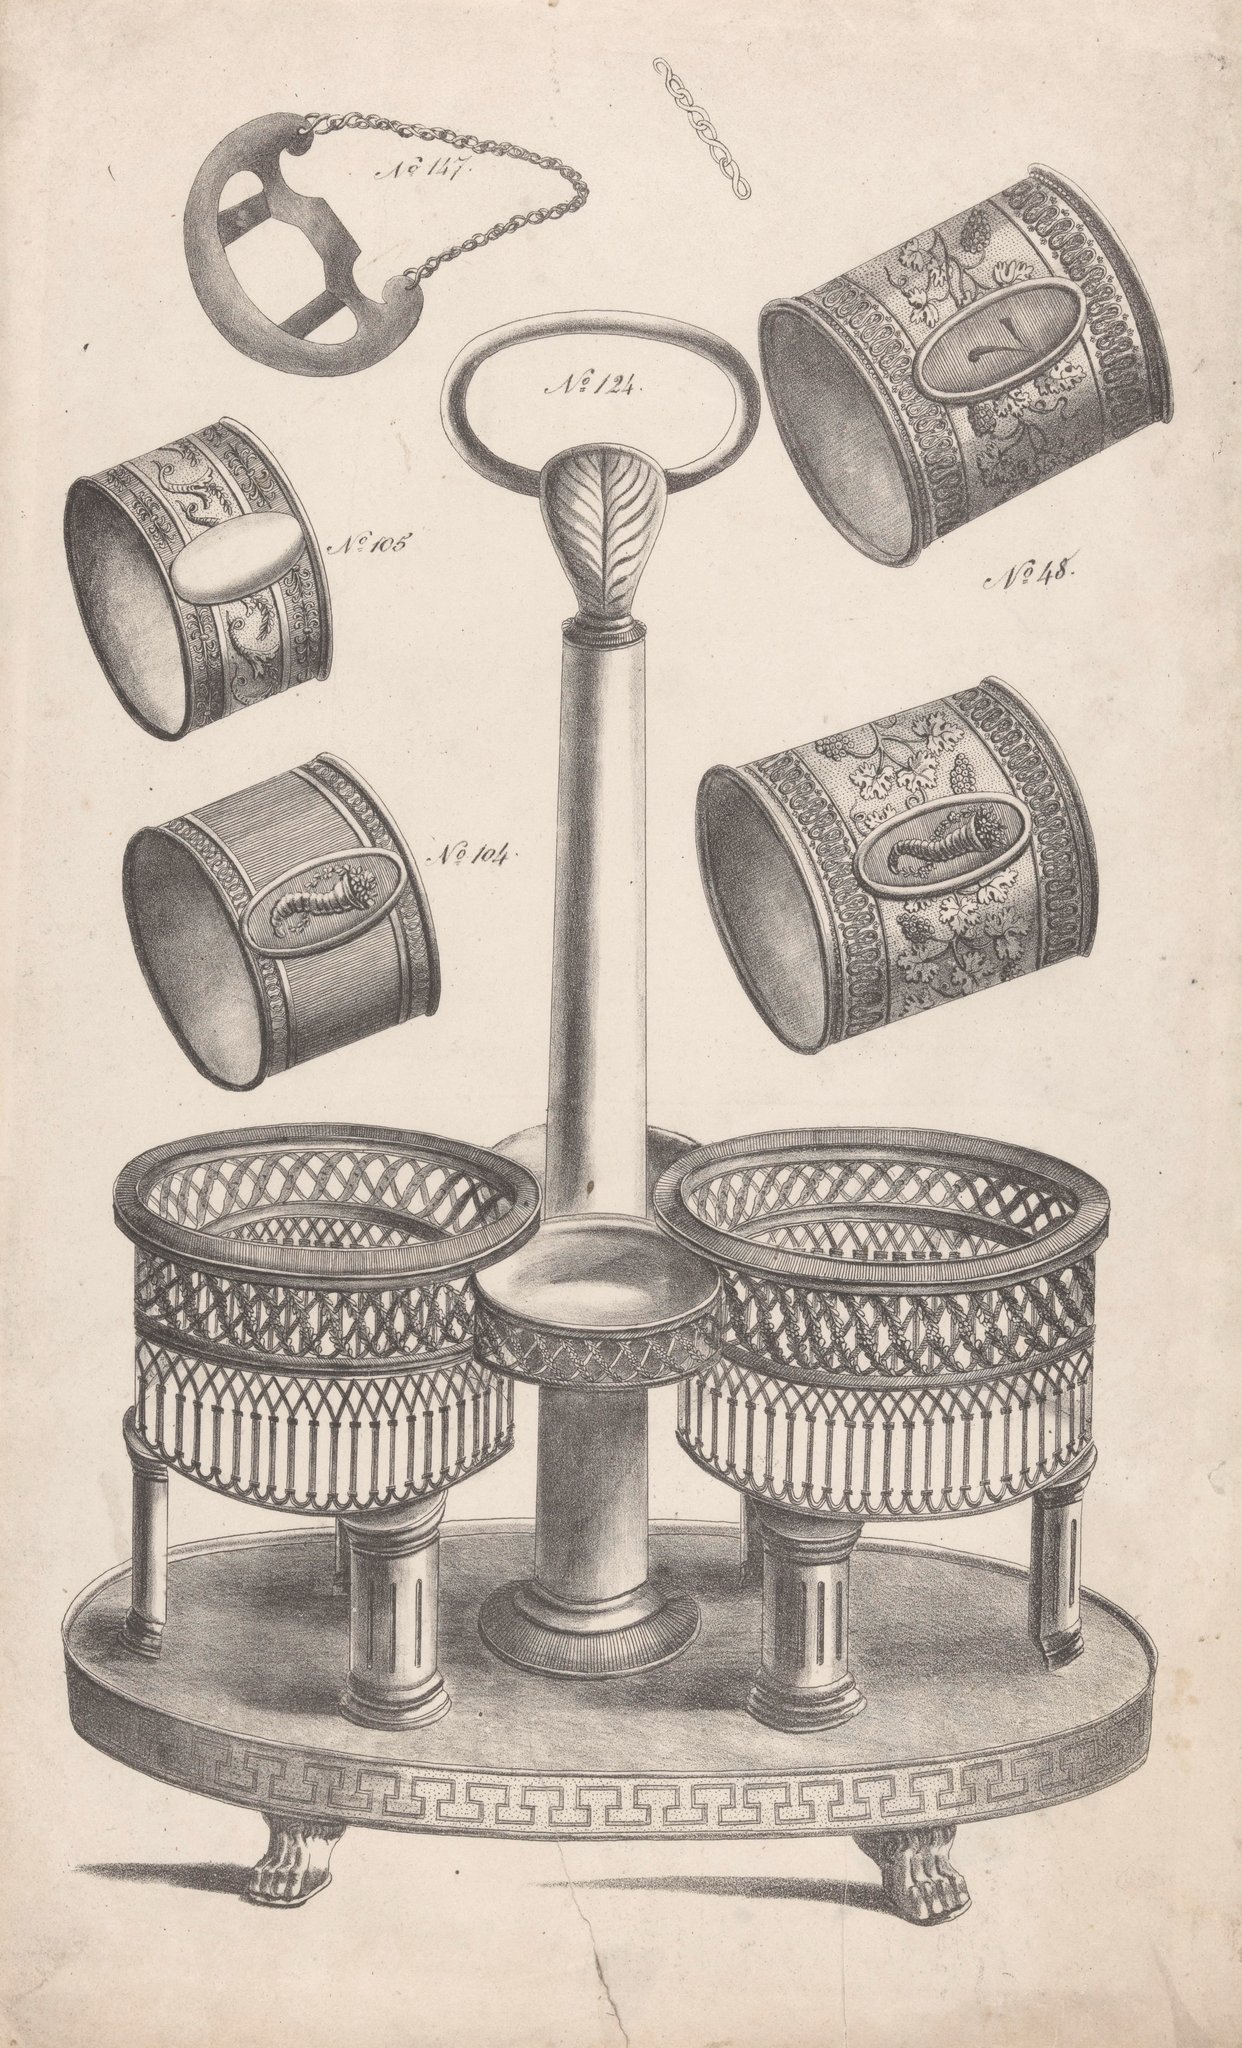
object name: ornament print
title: Empirevoorwerpen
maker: Anonymous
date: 1820-1840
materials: paper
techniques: lithograph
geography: germany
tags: serving-dish, platter, napkin-ring, styles in the fine arts (+ later developments)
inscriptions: collector's mark: Lugt 2760, collector's mark: Lugt 2228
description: Ontwerp voor een plateau met hengsel en twee ronde opengewerkte houders. Daarboven vier ronde ringen, mogelijk servetringen, gedecoreerd met druivenranken en hoornen des overvloeds. Alle objecten zijn genummerd.